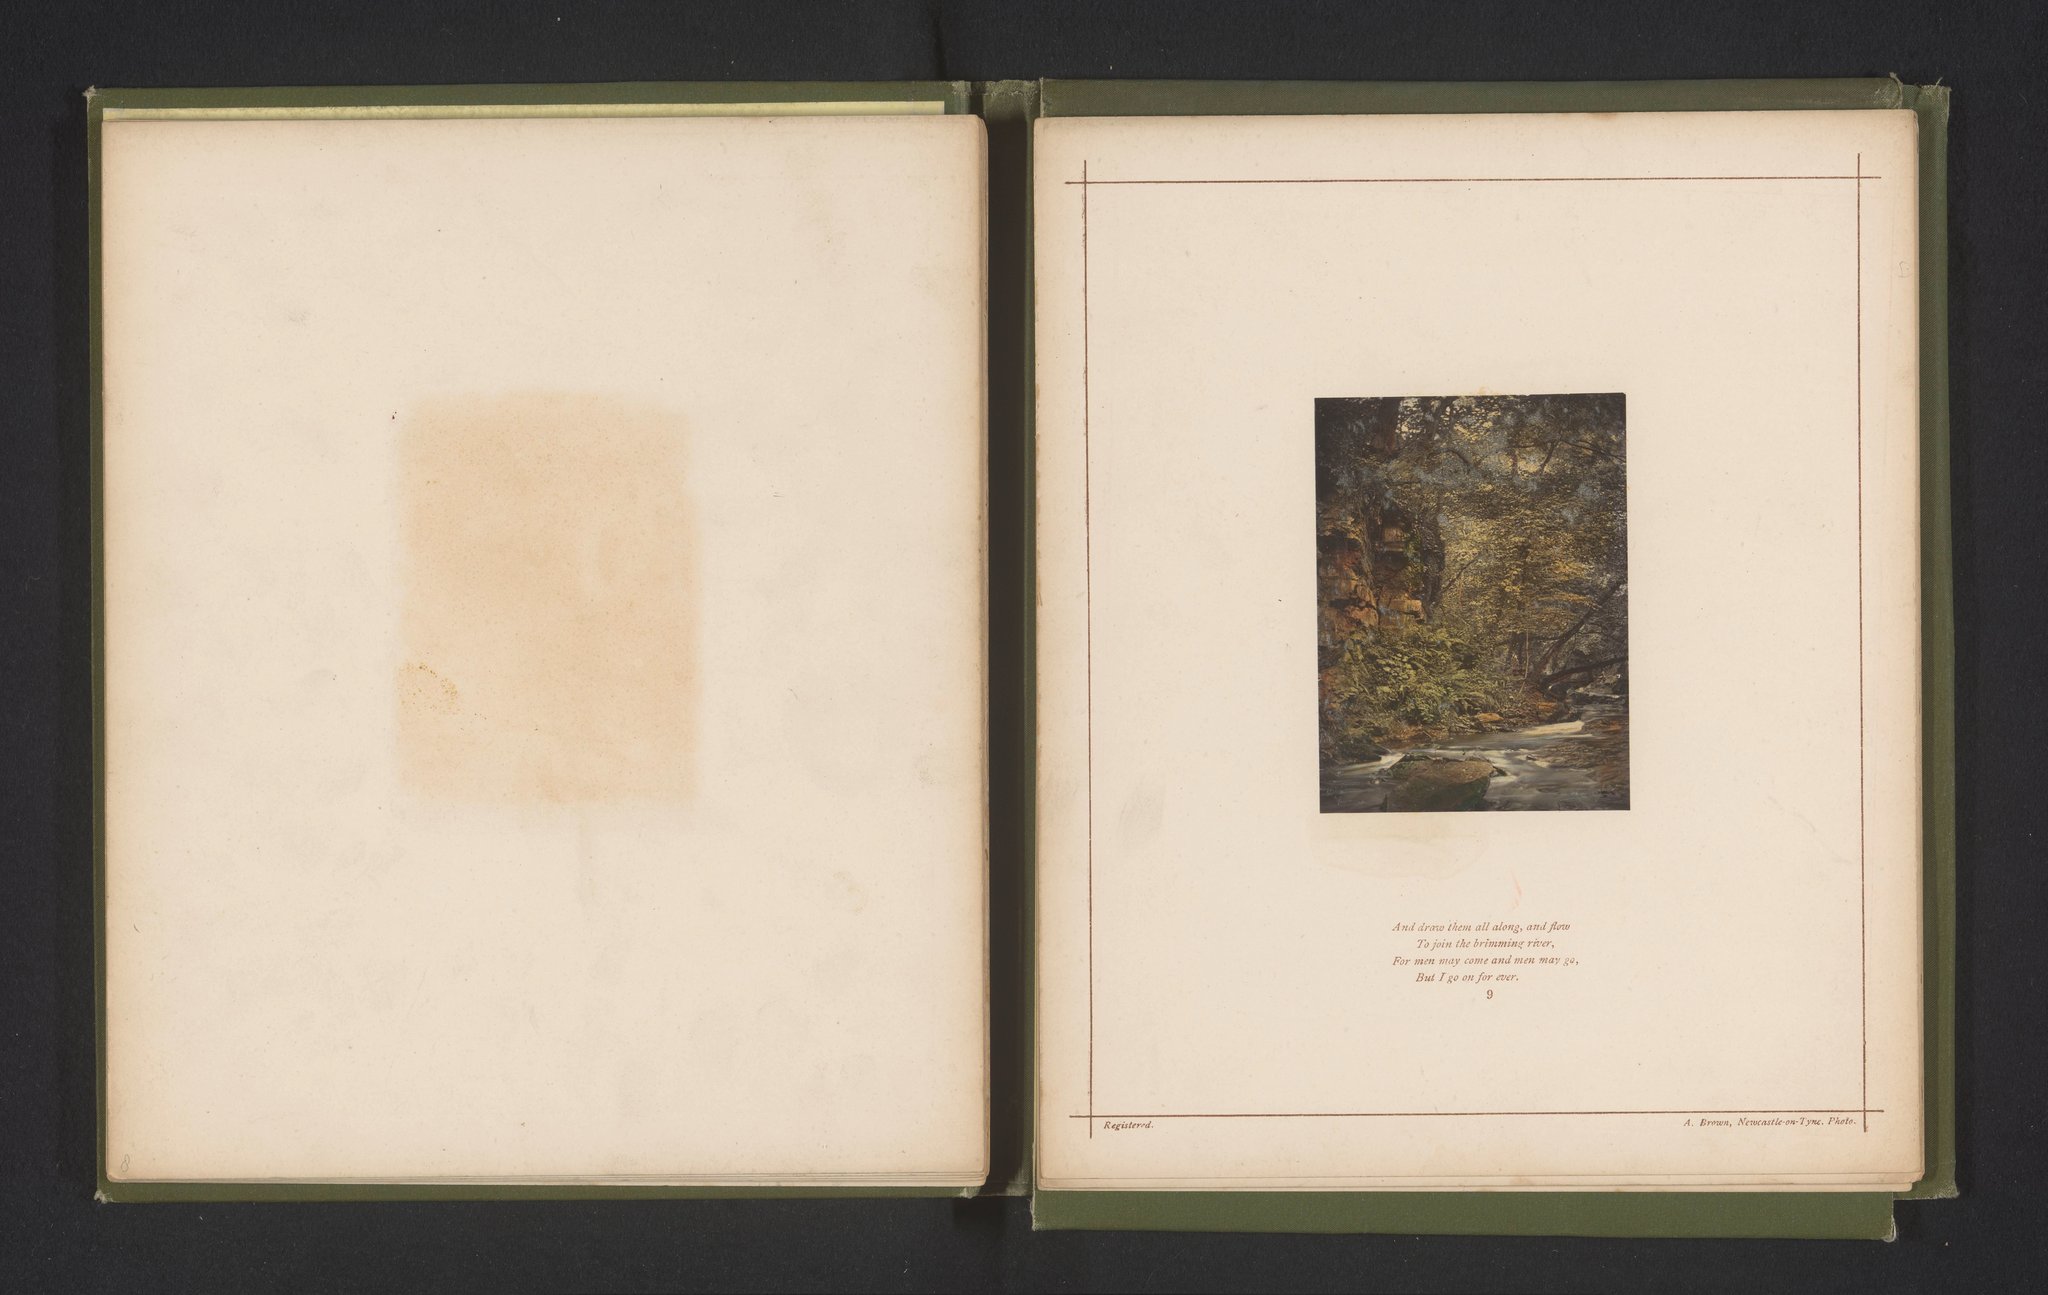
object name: photograph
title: Gezicht op de beek Skelton Beck nabij Saltburn-by-the-Sea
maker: arthur brown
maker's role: fotograaf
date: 1874-1879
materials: paper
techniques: carbon print, hand coloring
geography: north yorkshire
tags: brook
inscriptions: inscription: ‘And draw them all along (...) But I go on for ever.’, number: ‘9’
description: Deze foto maakt deel uit van een omslag met dertien foto's.